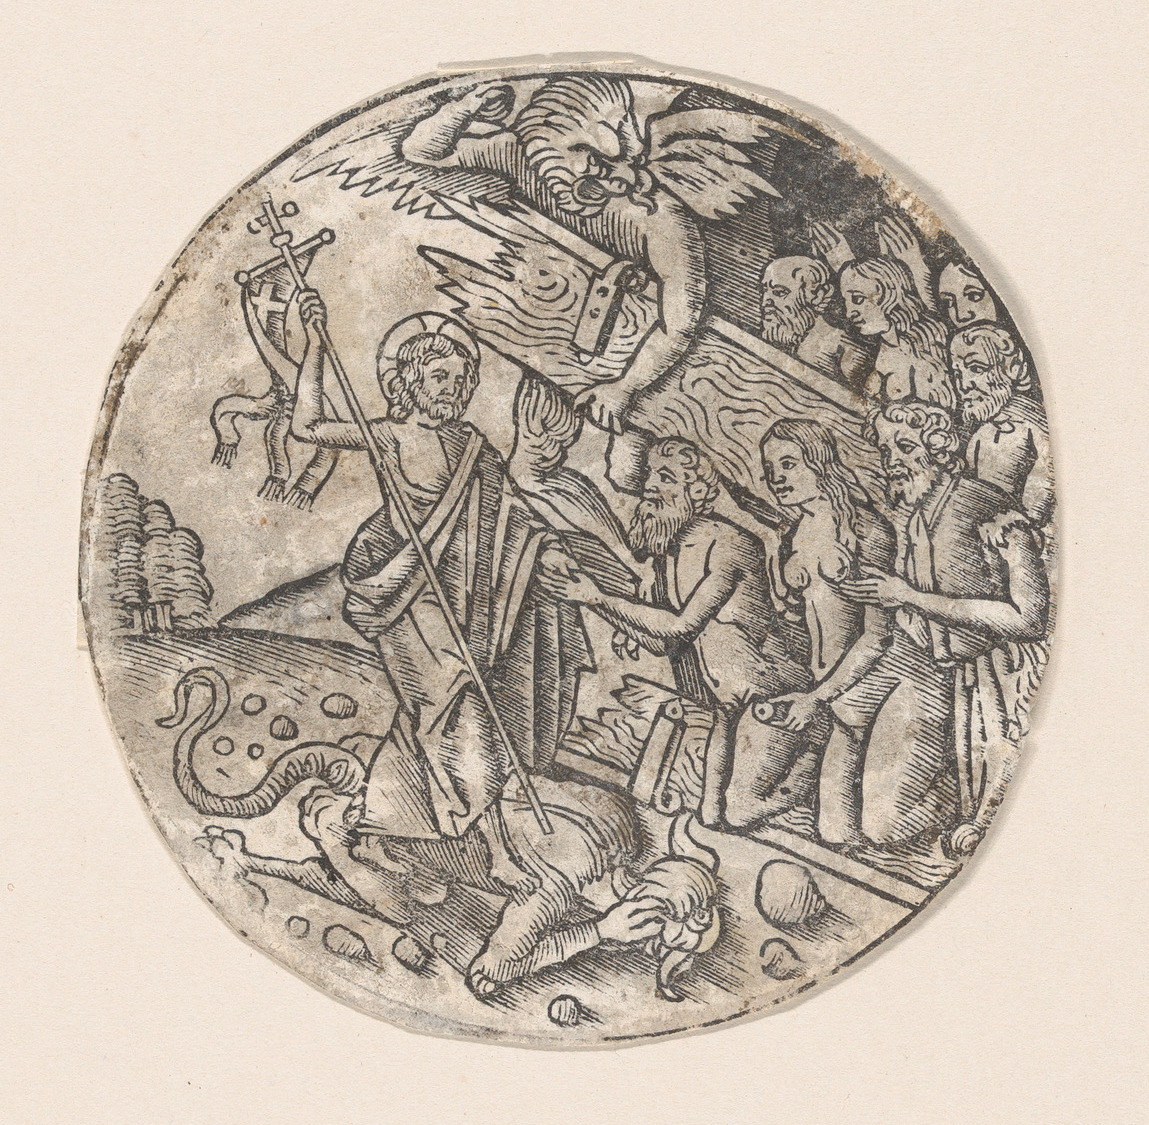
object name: print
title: Christ in Limbo, a circular composition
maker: anonymous, italian, 16th century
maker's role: artist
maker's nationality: italian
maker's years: 1500-1600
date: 1520-1550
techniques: woodcut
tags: male nudes,female nudes,christ